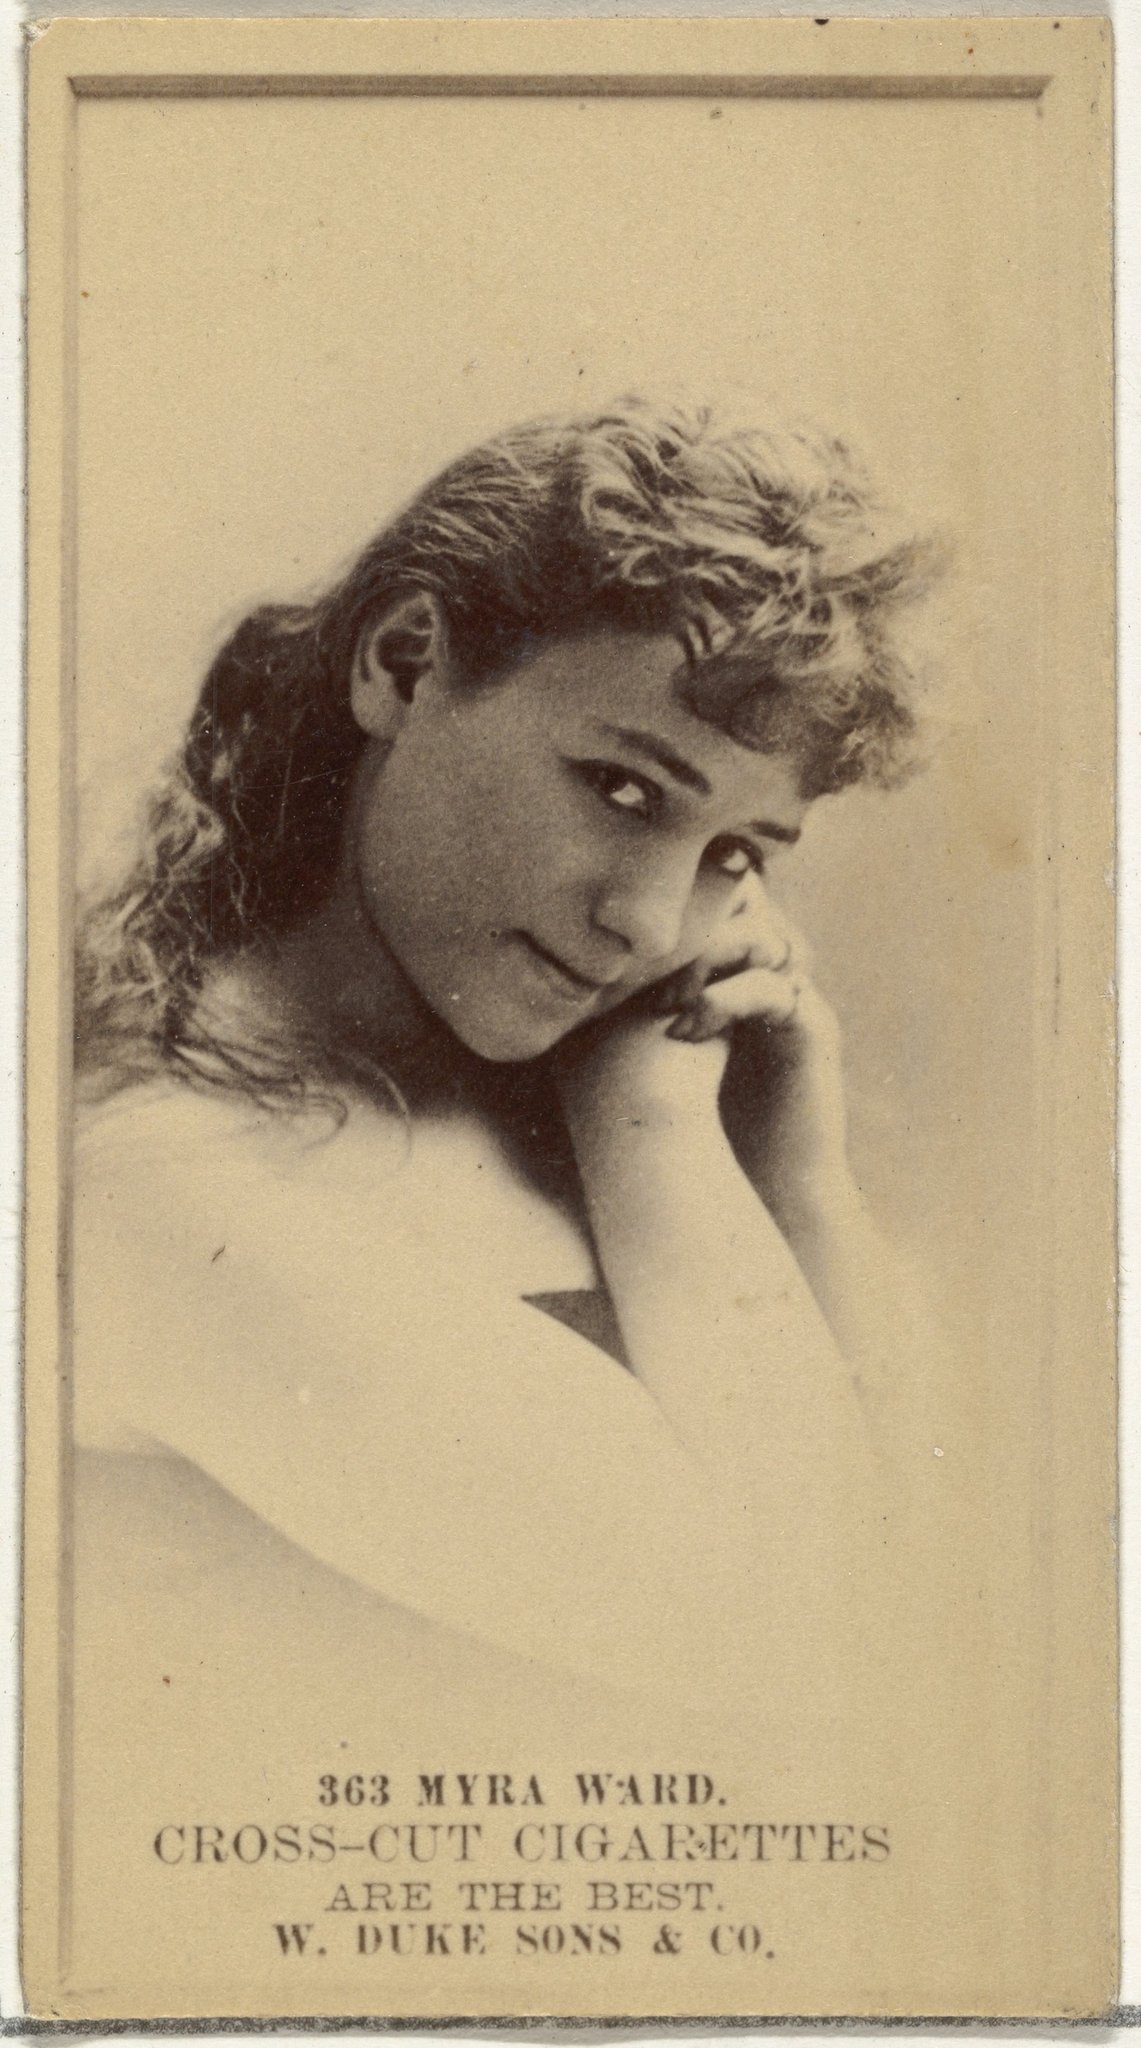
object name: photograph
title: Card Number 363, Myra Ward, from the Actors and Actresses series (N145-3) issued by Duke Sons & Co. to promote Cross Cut Cigarettes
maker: w. duke, sons & co.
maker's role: publisher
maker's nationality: american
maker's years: 1870-1920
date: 1880-1889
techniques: albumen silver print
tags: portraits,women,actresses